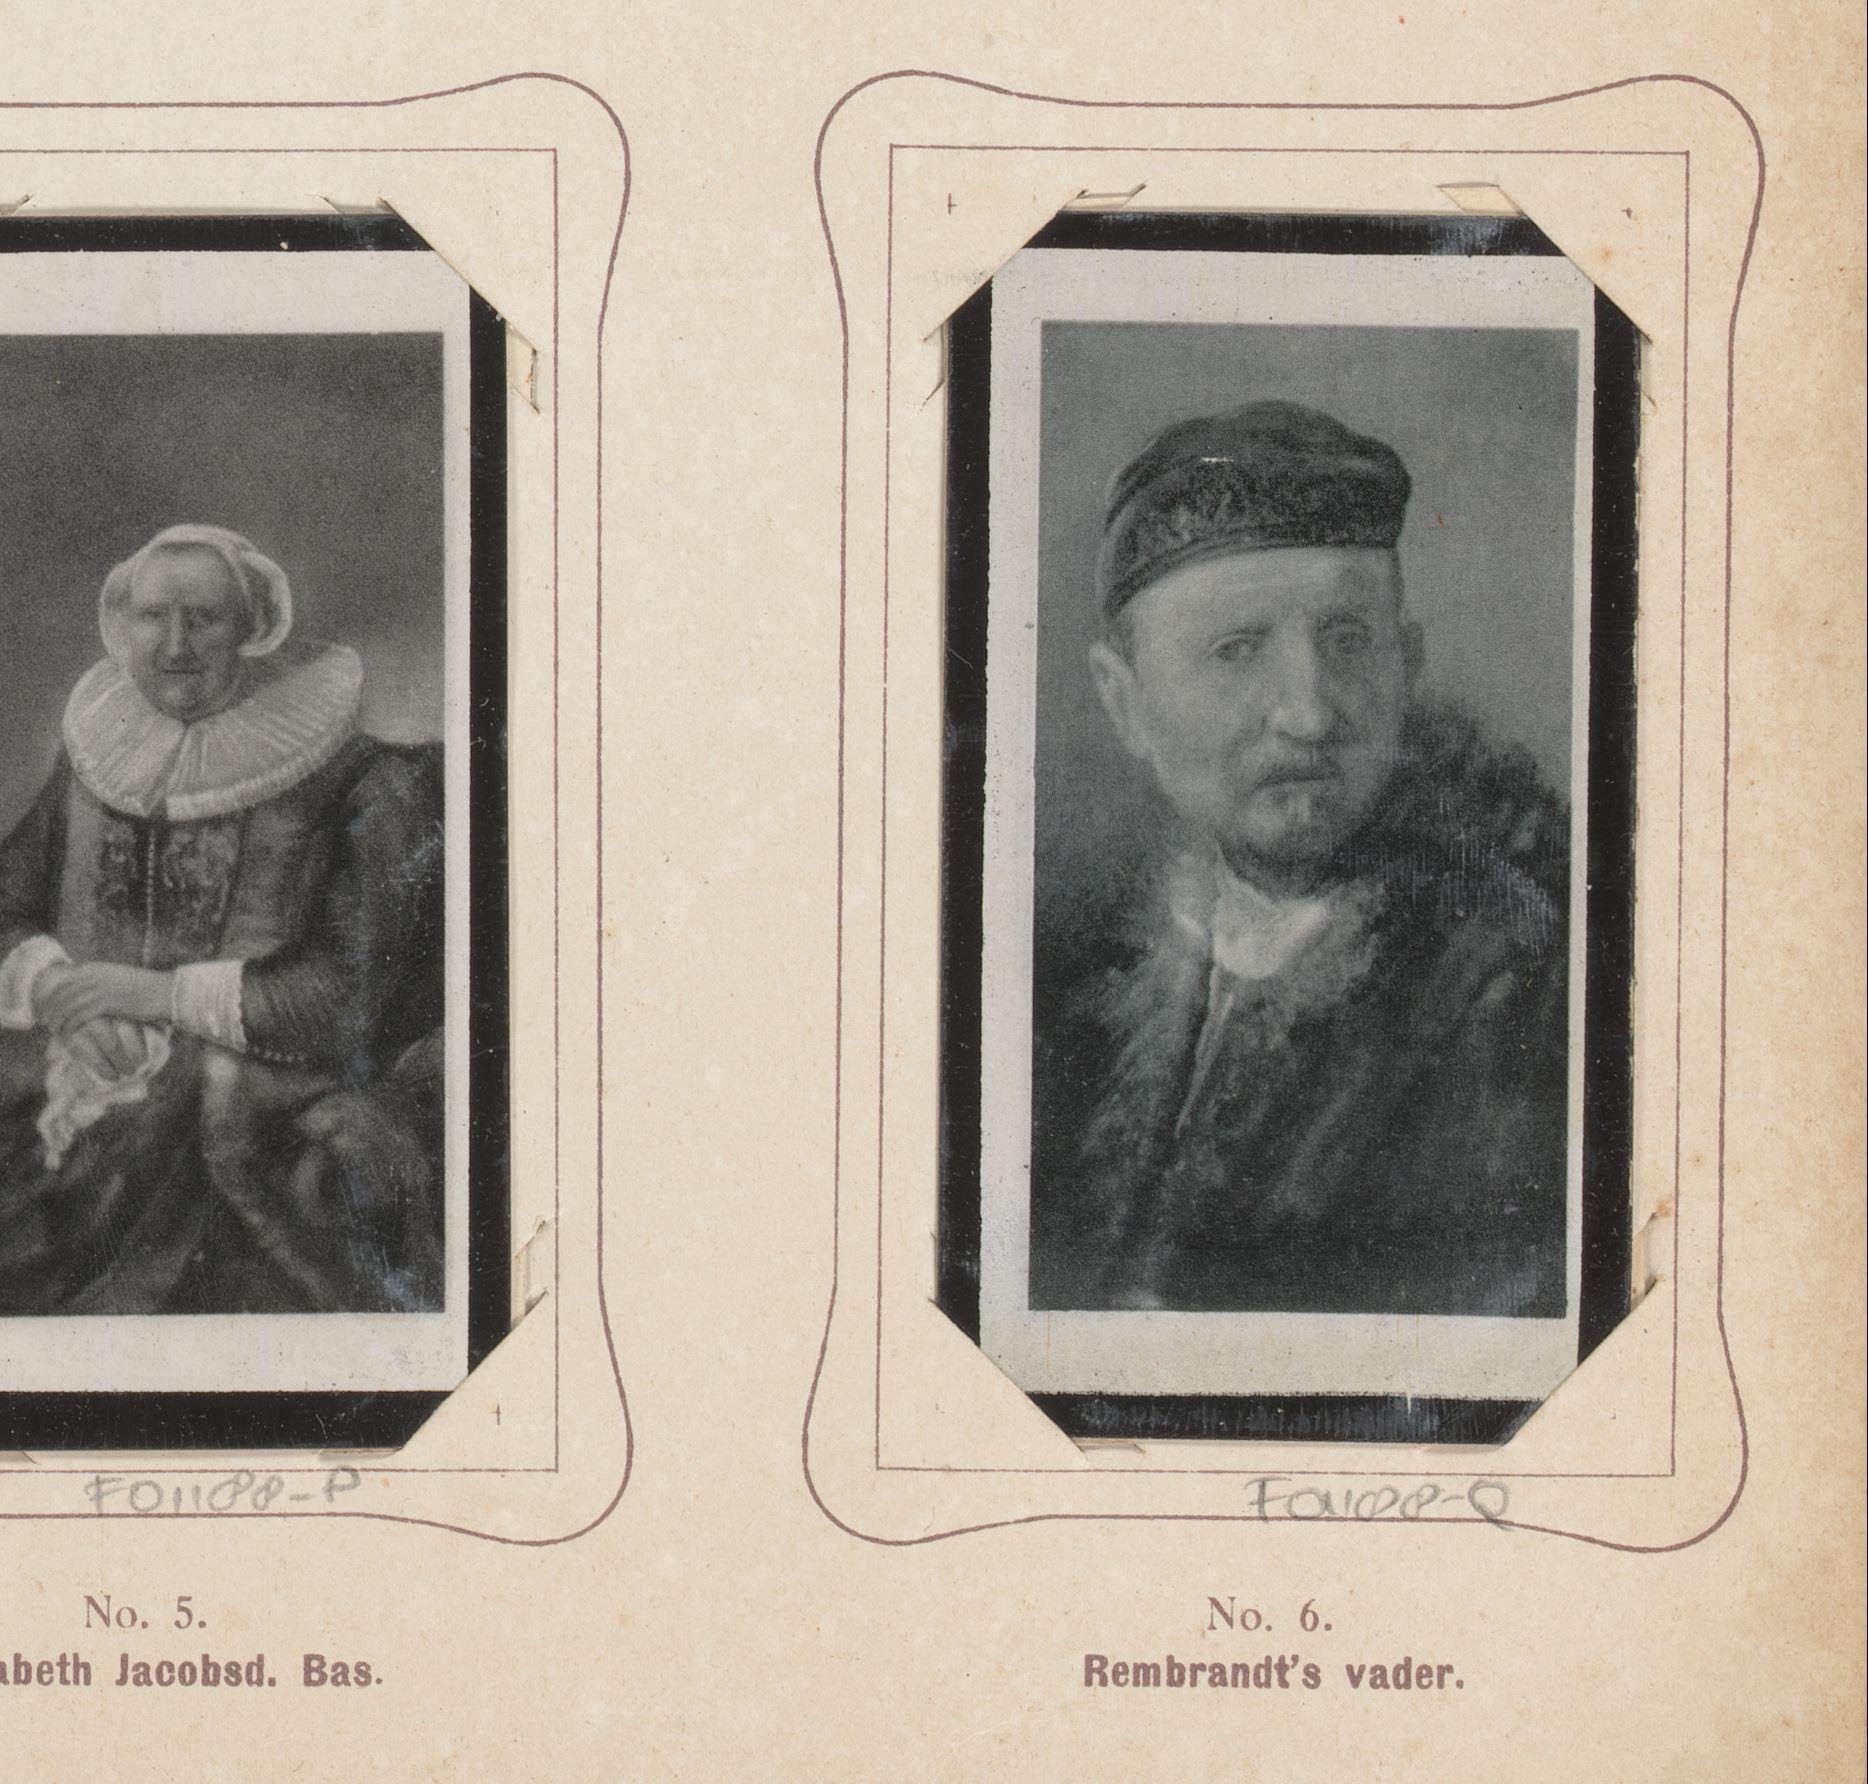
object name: album leaf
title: Reproductie van een geschilderd portret van Harmen Gerritsz. van Rijn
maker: Anonymous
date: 1906-1907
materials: paper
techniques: photograph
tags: can hook, historical persons - bb - woman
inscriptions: inscription: ‘No. 6./ Rembrandt's vader.’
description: Deze prent maakt deel uit van een album.